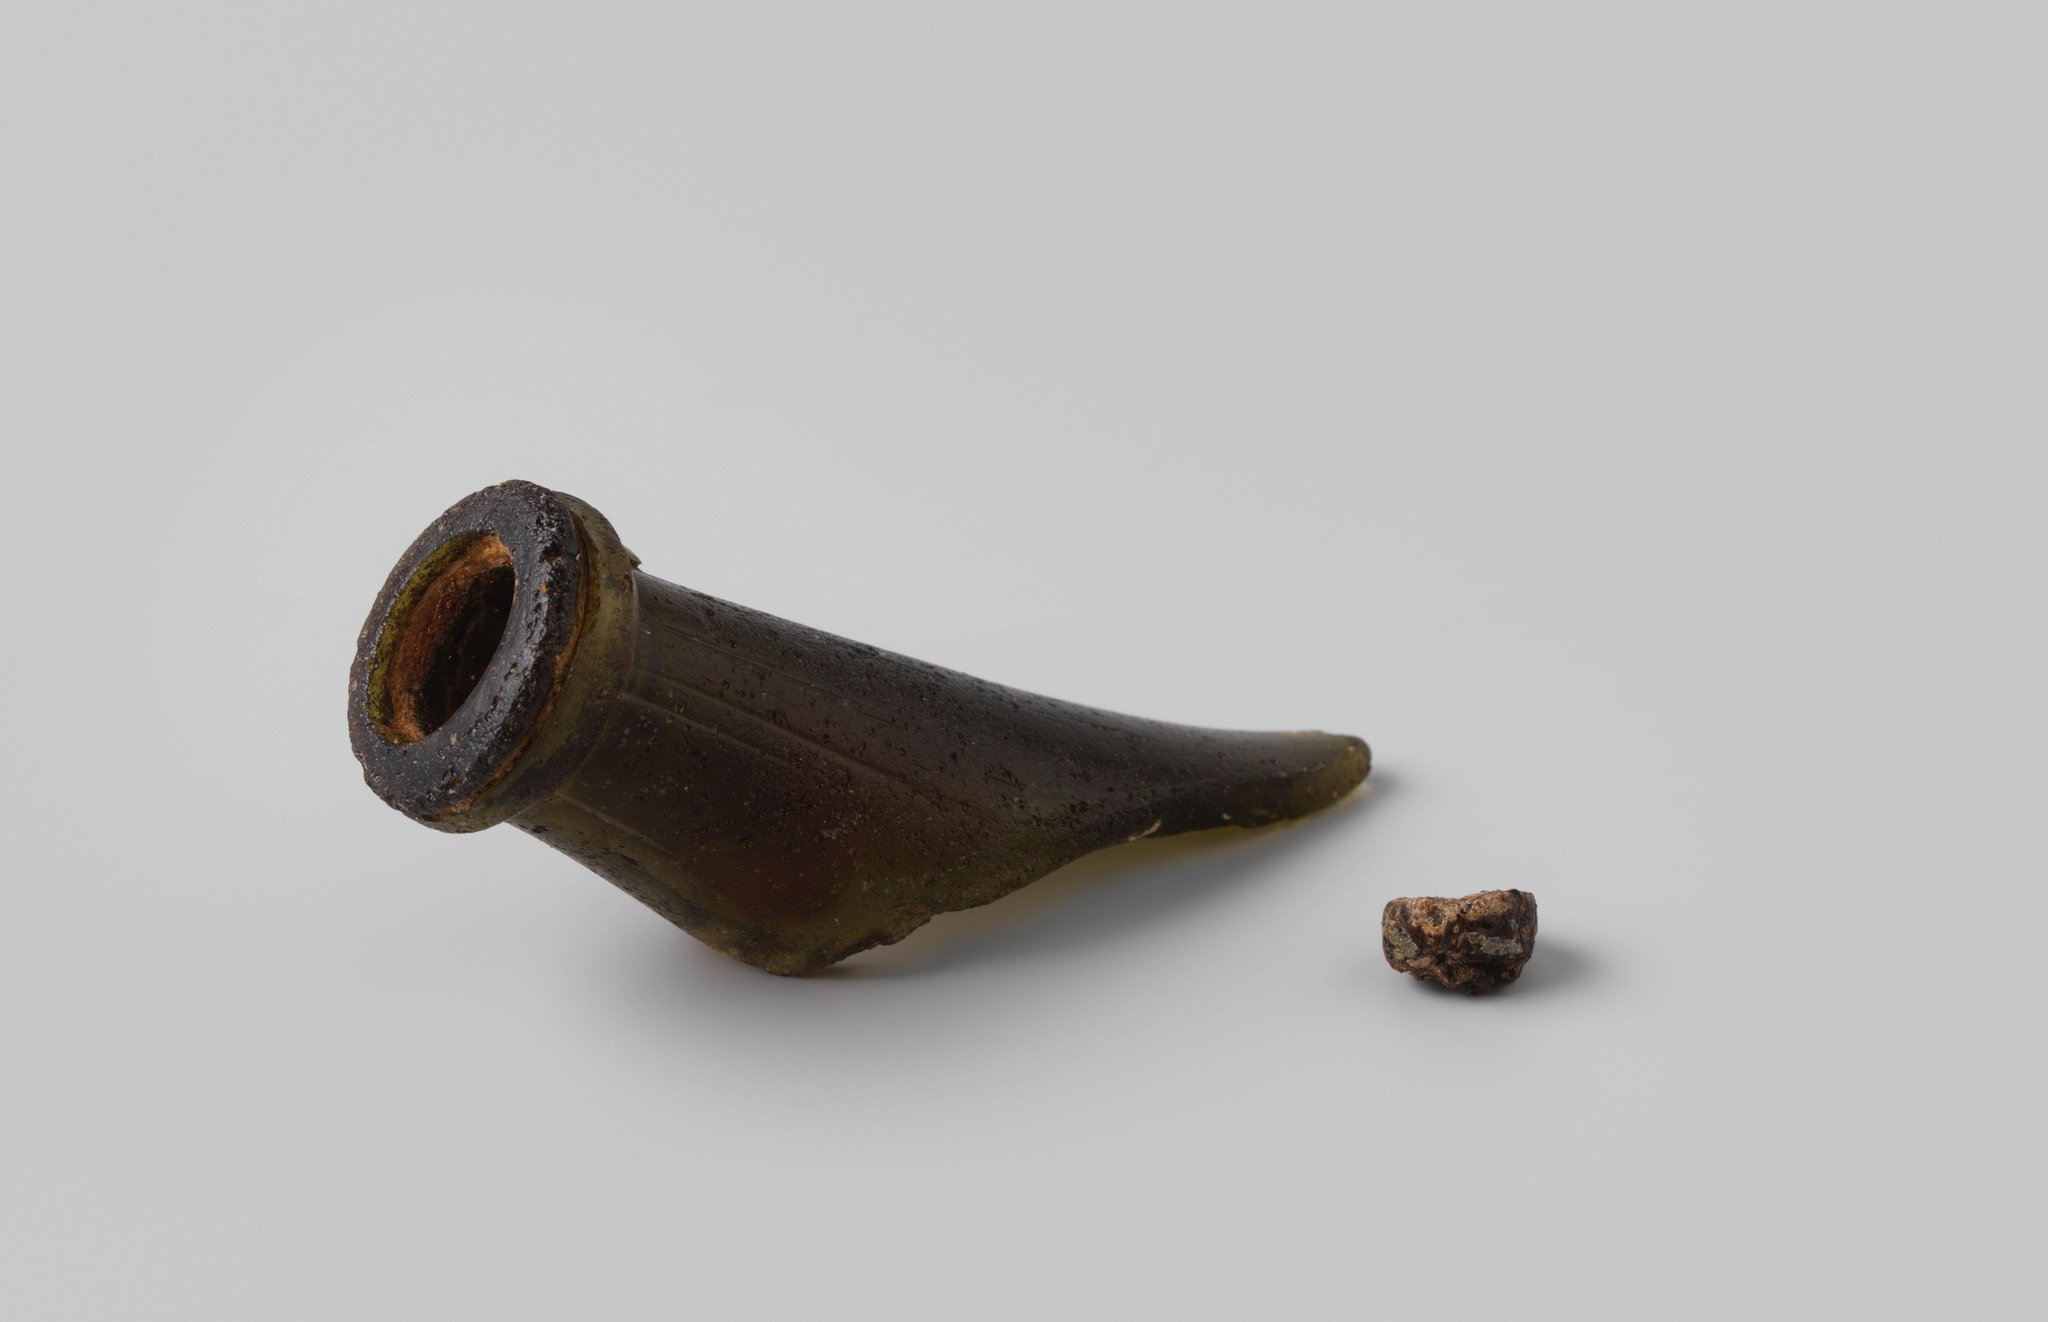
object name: sherd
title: Hals en kurk van een wijnfles uit het wrak van de Oost-Indiëvaarder Hollandia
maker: Anonymous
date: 1700-1743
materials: cork, glass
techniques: green glass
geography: netherlands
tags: verenigde oostindische compagnie, hollandia (schip)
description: Wine bottle, continental production, neck, onion-shaped bottle or bottle with vertical side; fragm, vs-string rim.